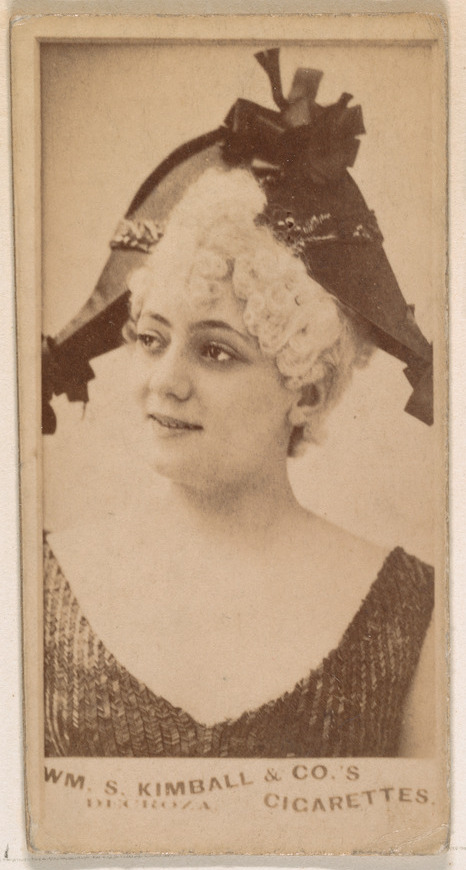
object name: photograph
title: Miss Decroza, from the Actresses series (N203) issued by Wm. S. Kimball & Co.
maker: william s. kimball & company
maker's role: publisher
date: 1889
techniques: color lithograph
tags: portraits,women,actresses